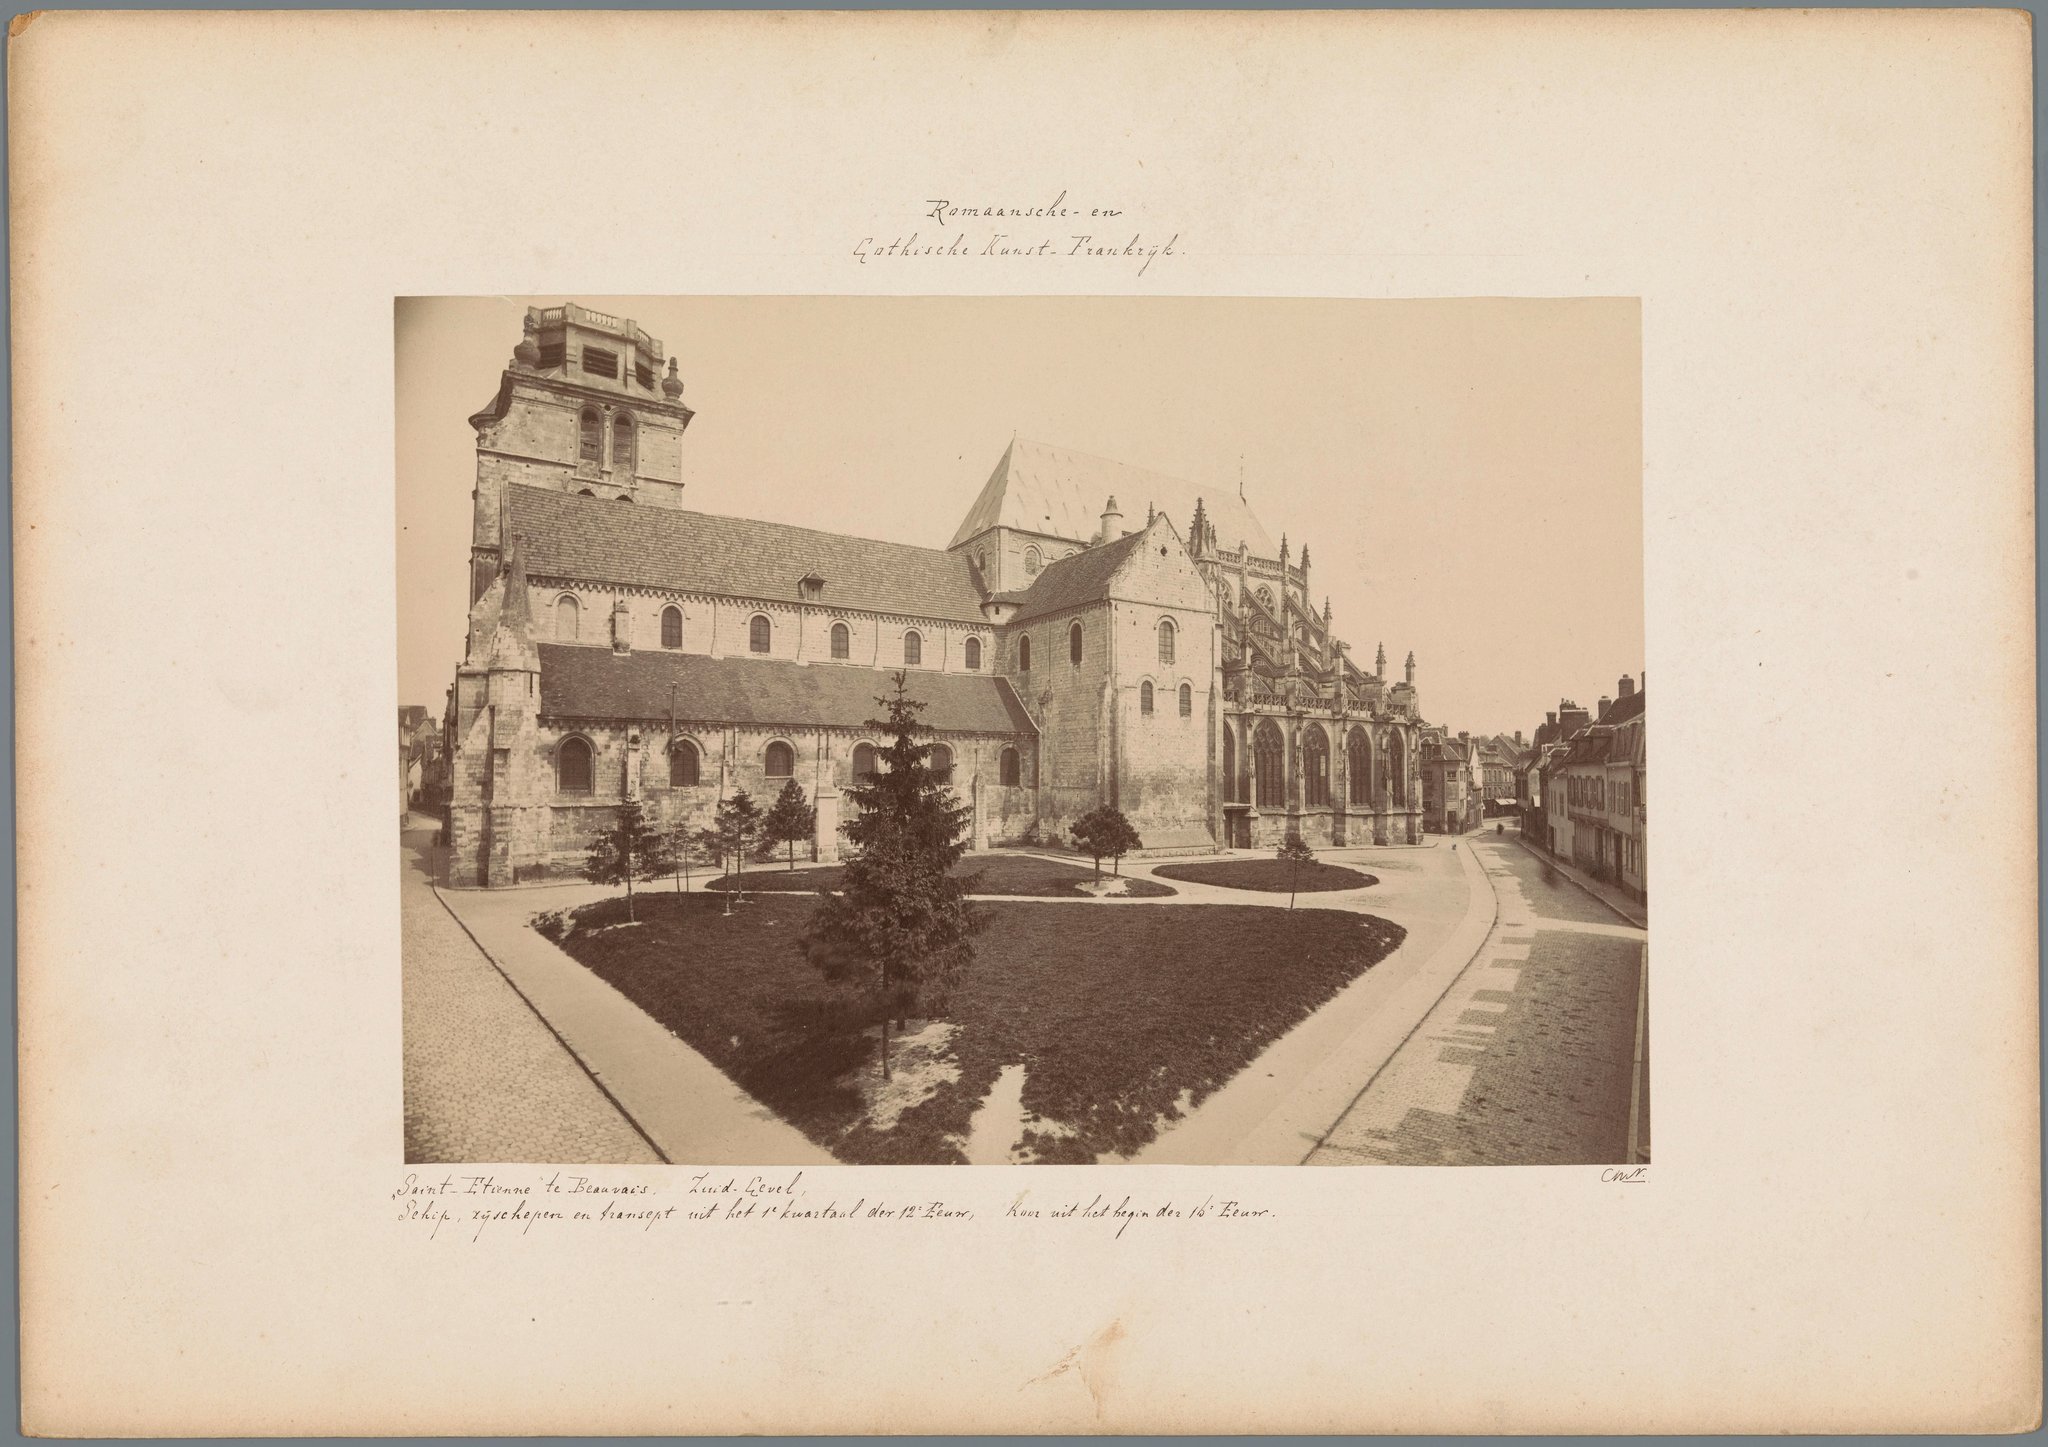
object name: photograph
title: Gezicht op de zuidelijke gevel van de kerk Saint-Étienne te Beauvais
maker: Anonymous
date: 1875-1900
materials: cardboard, photographic support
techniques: albumen print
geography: beauvais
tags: church (exterior), façade (of house or building)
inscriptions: collector's mark: ‘INSTITUUT VOOR KUNST- NIJVERHEIDSONDERWIJS GABRIËL METSUSTRAAT No. 16. AMSTERDAM’, inscription: ‘CWN.’, inscription: ‘Romaansche - en Gothische Kunst - Frankrijk. ,,Saint-Etienne'' te Beauvais (...) Koor uit het begin der 16e Eeuw.’